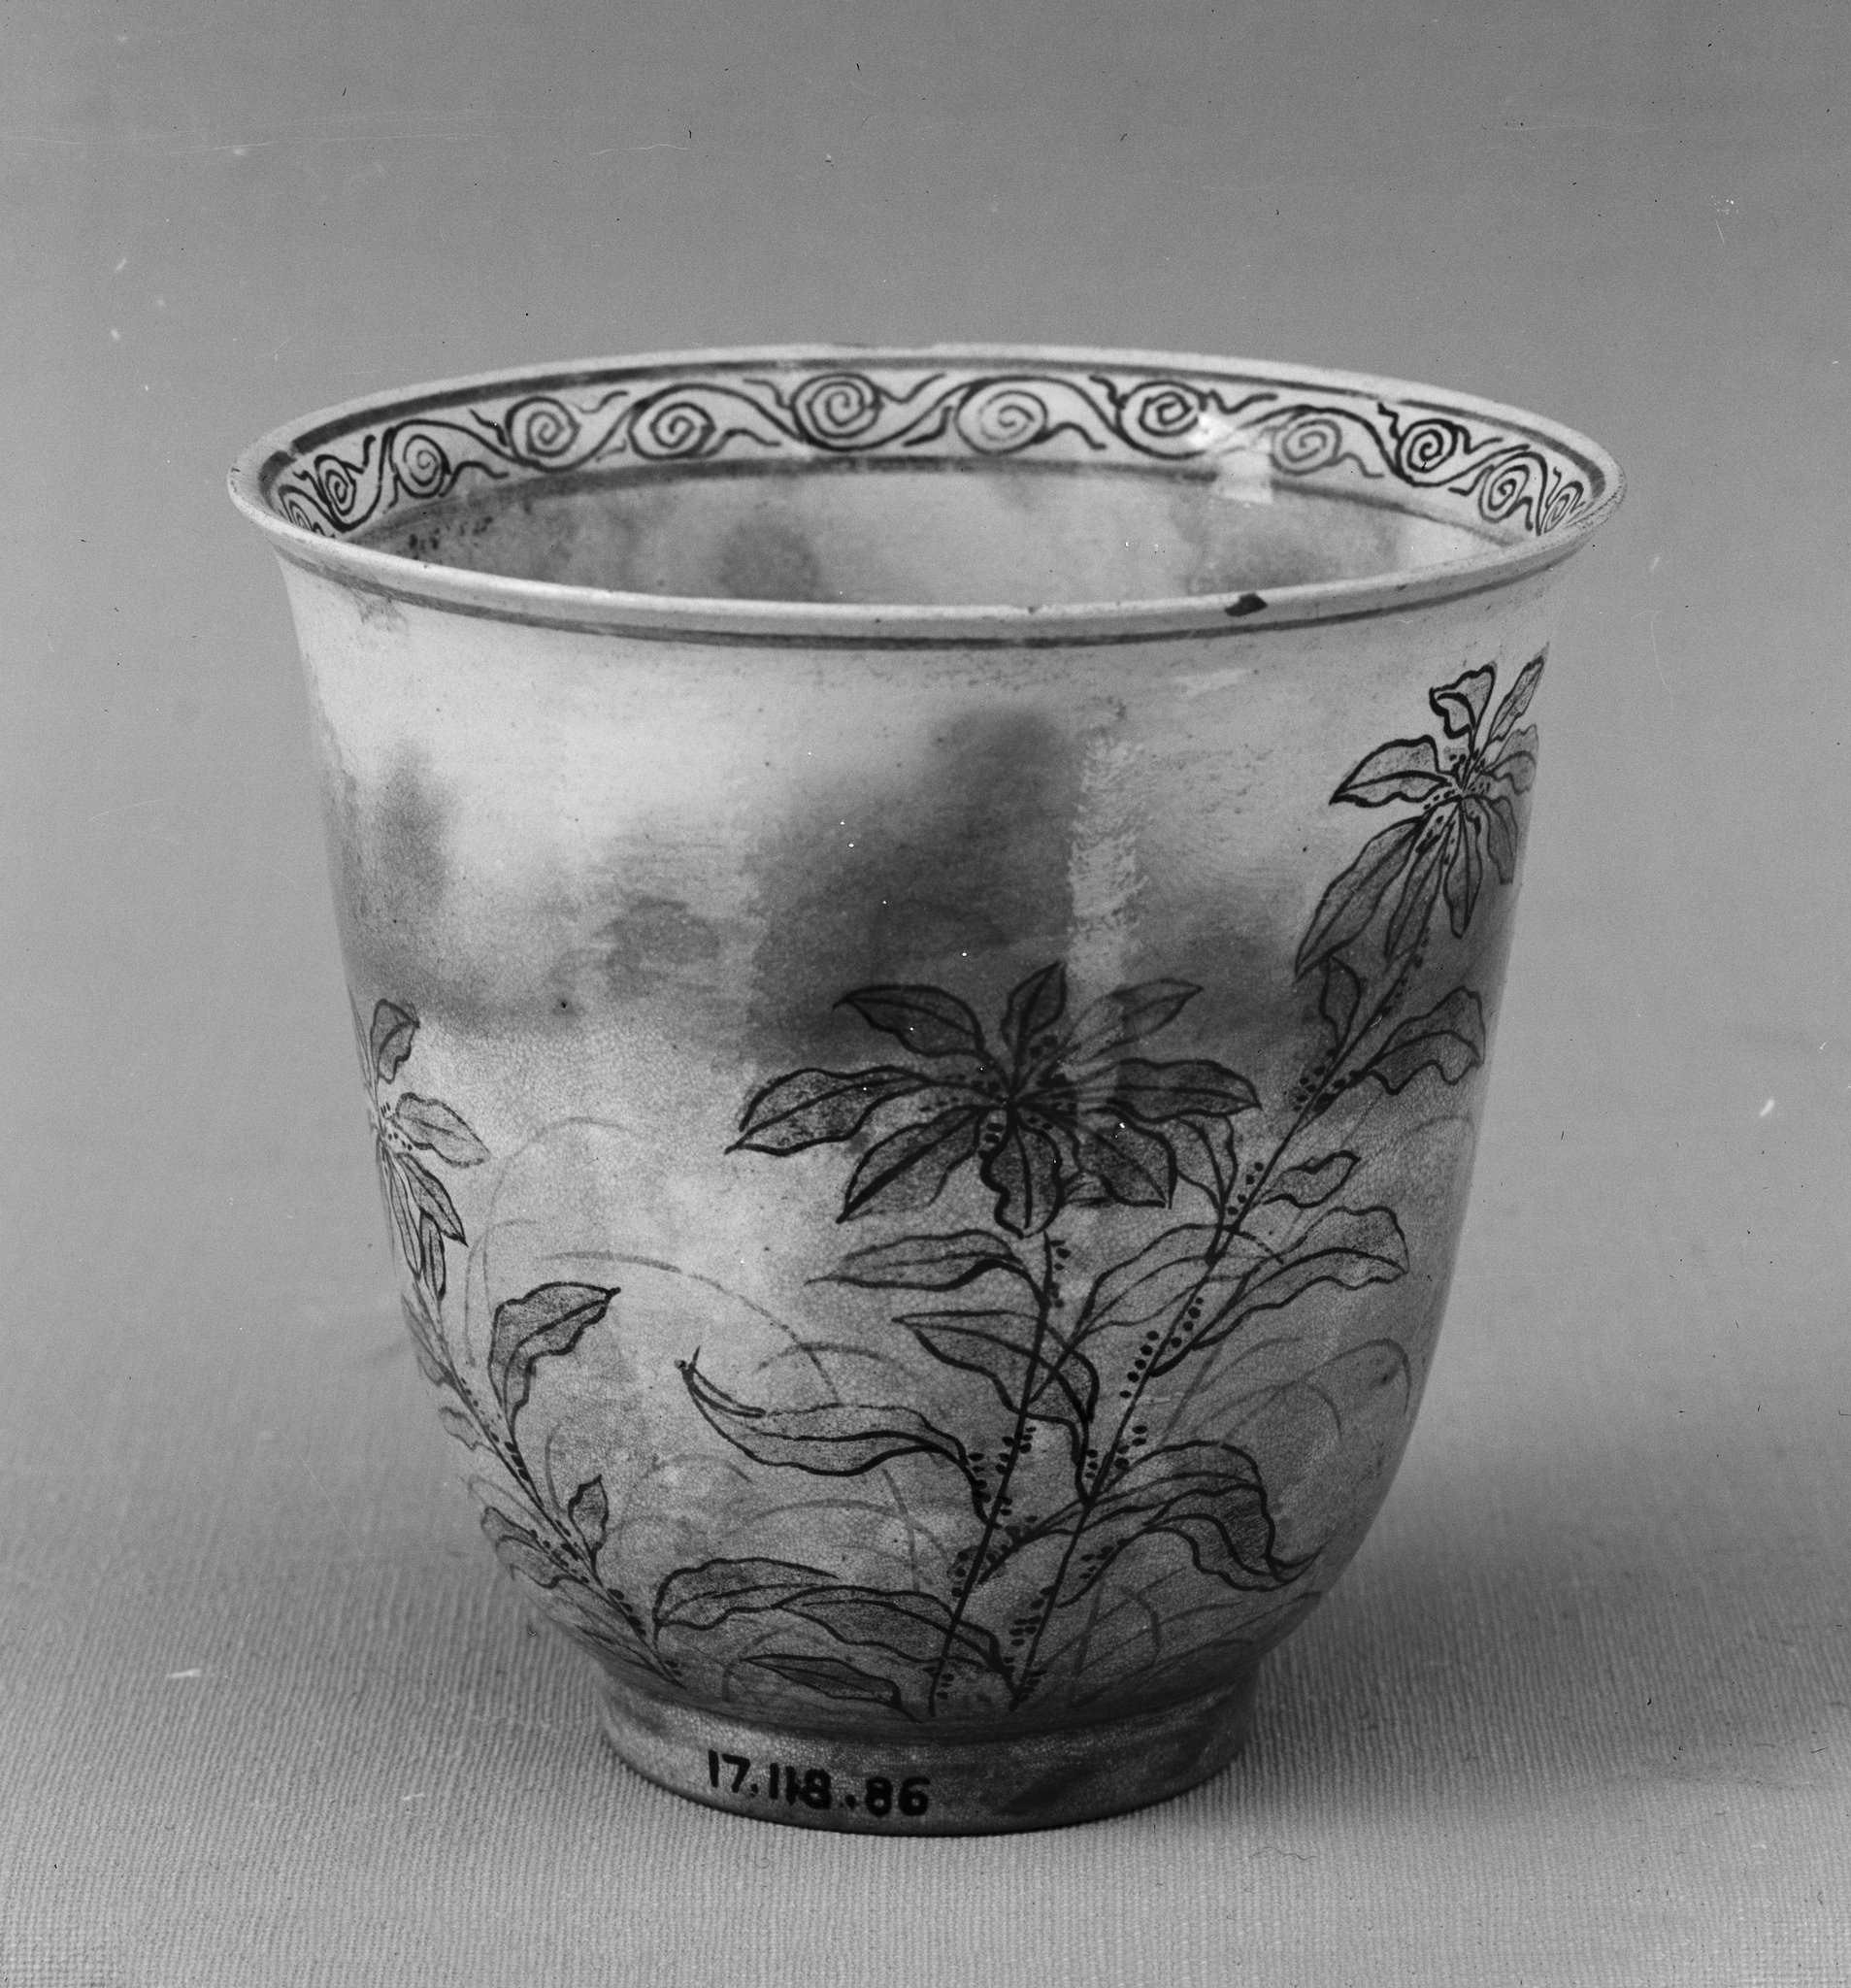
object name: cup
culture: japanese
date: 1620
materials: clay, enamel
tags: leaves